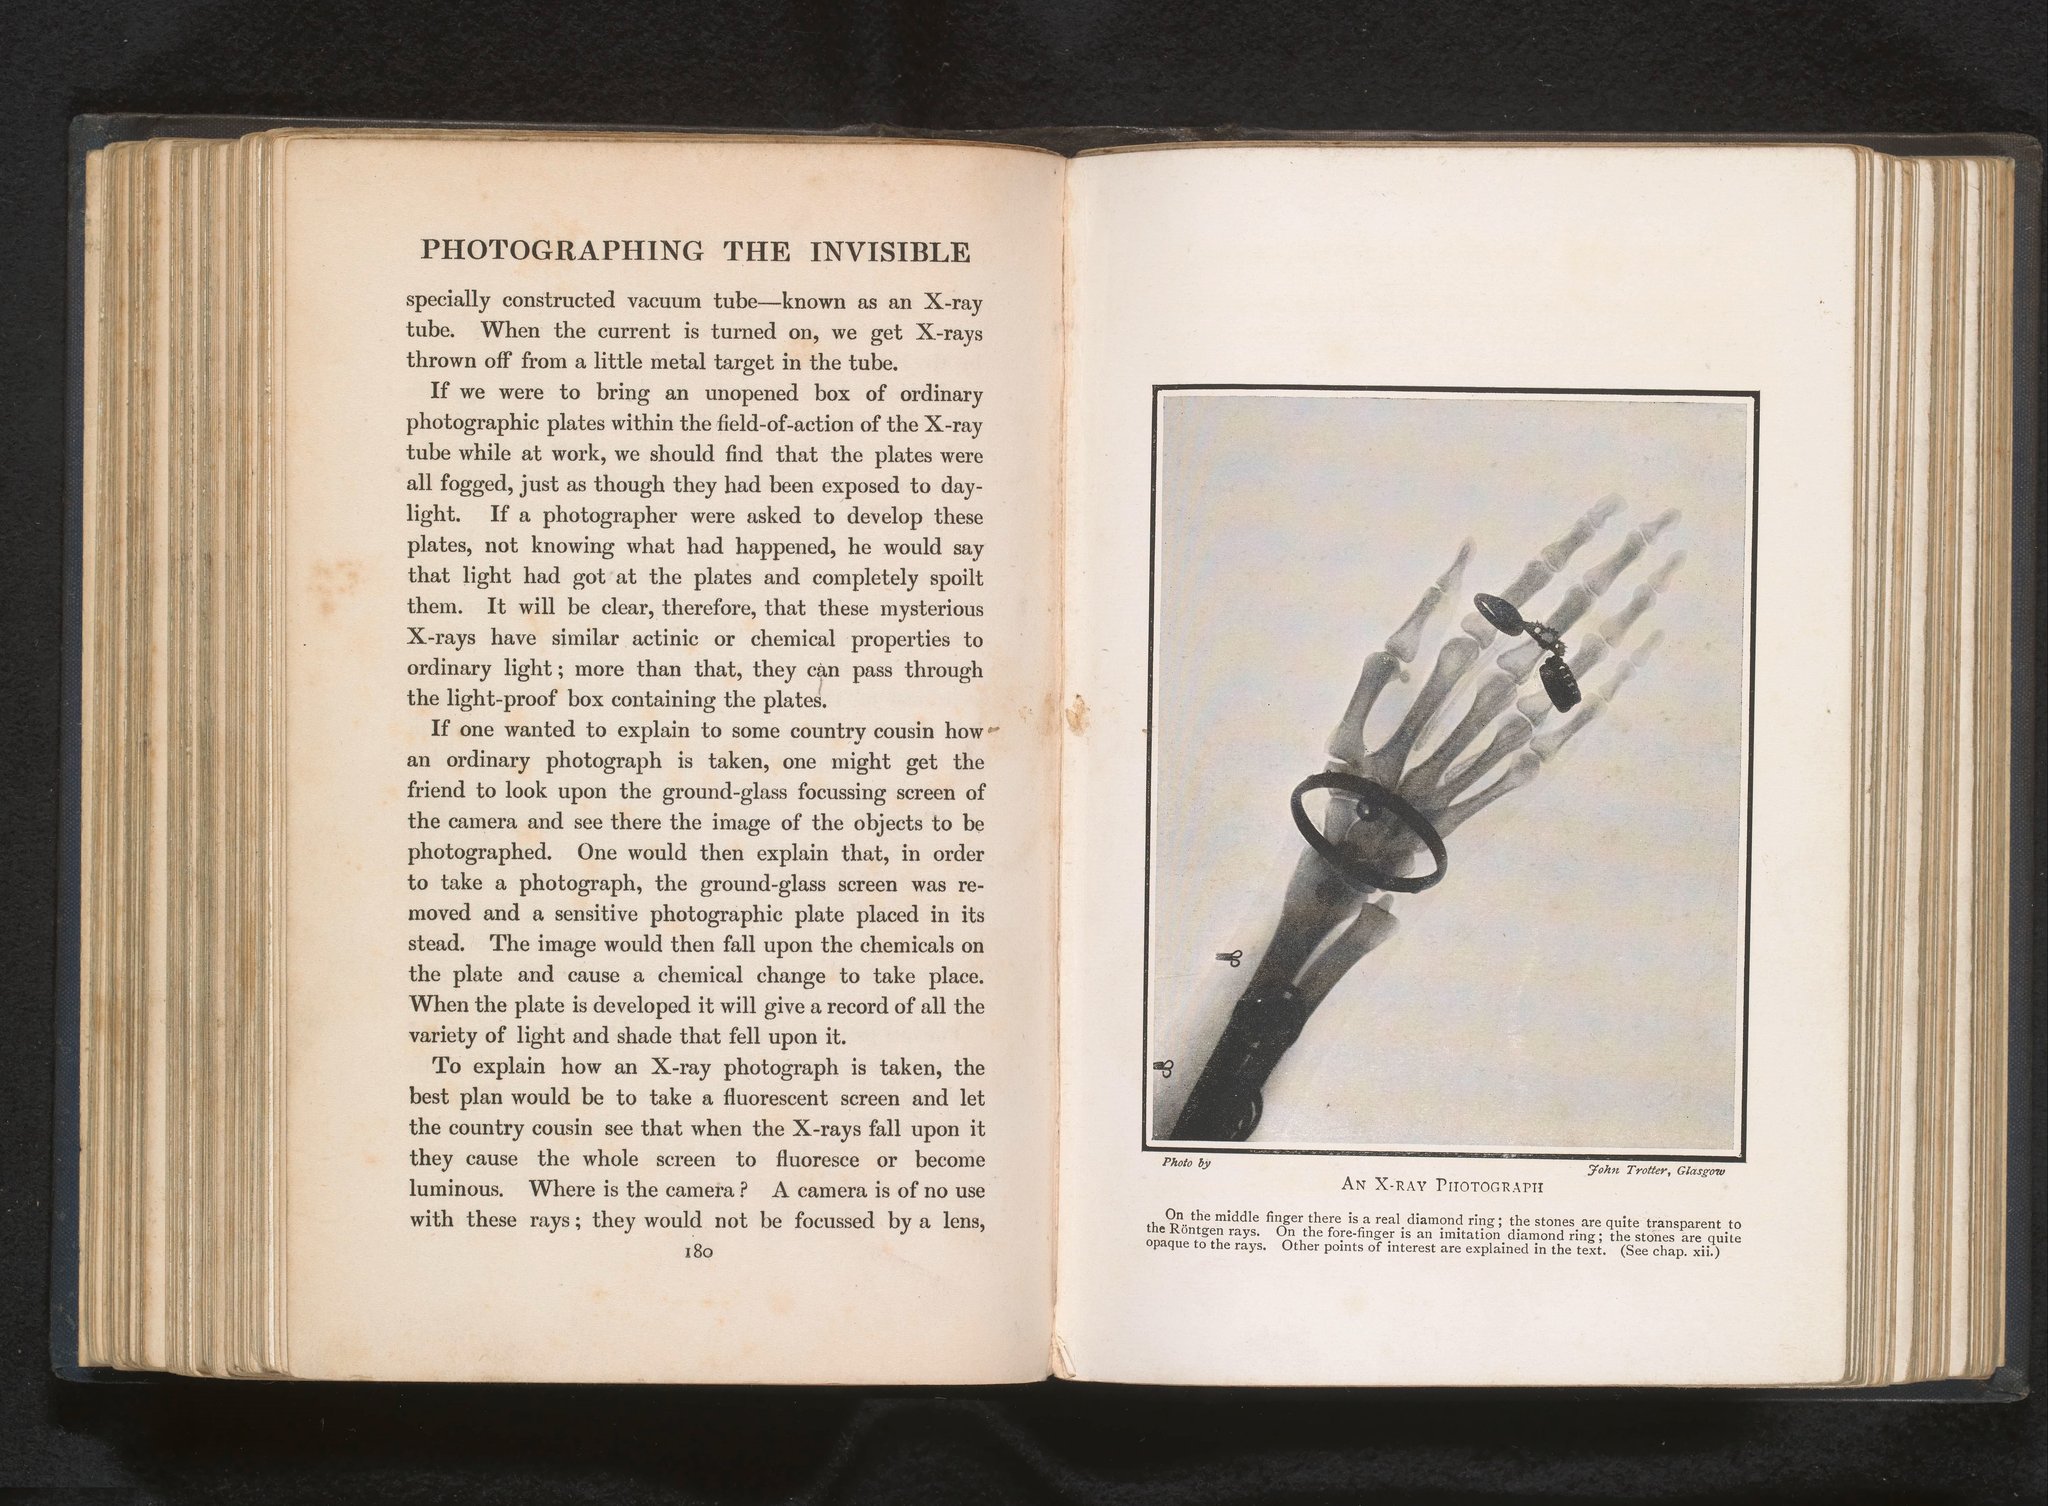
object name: photomechanical print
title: An X-Ray photograph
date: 1898-1908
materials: paper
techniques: autotype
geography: glasgow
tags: x-ray examination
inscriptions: inscription: ‘On the middle finger there is a real diamond ring; the stones are quite transparent to the Röntgen rays. On the fore-finger is a imitation diamond ring; the stones are quite opaque to the rays. Other point of interest are explained in the text. (See chap. xii.)’